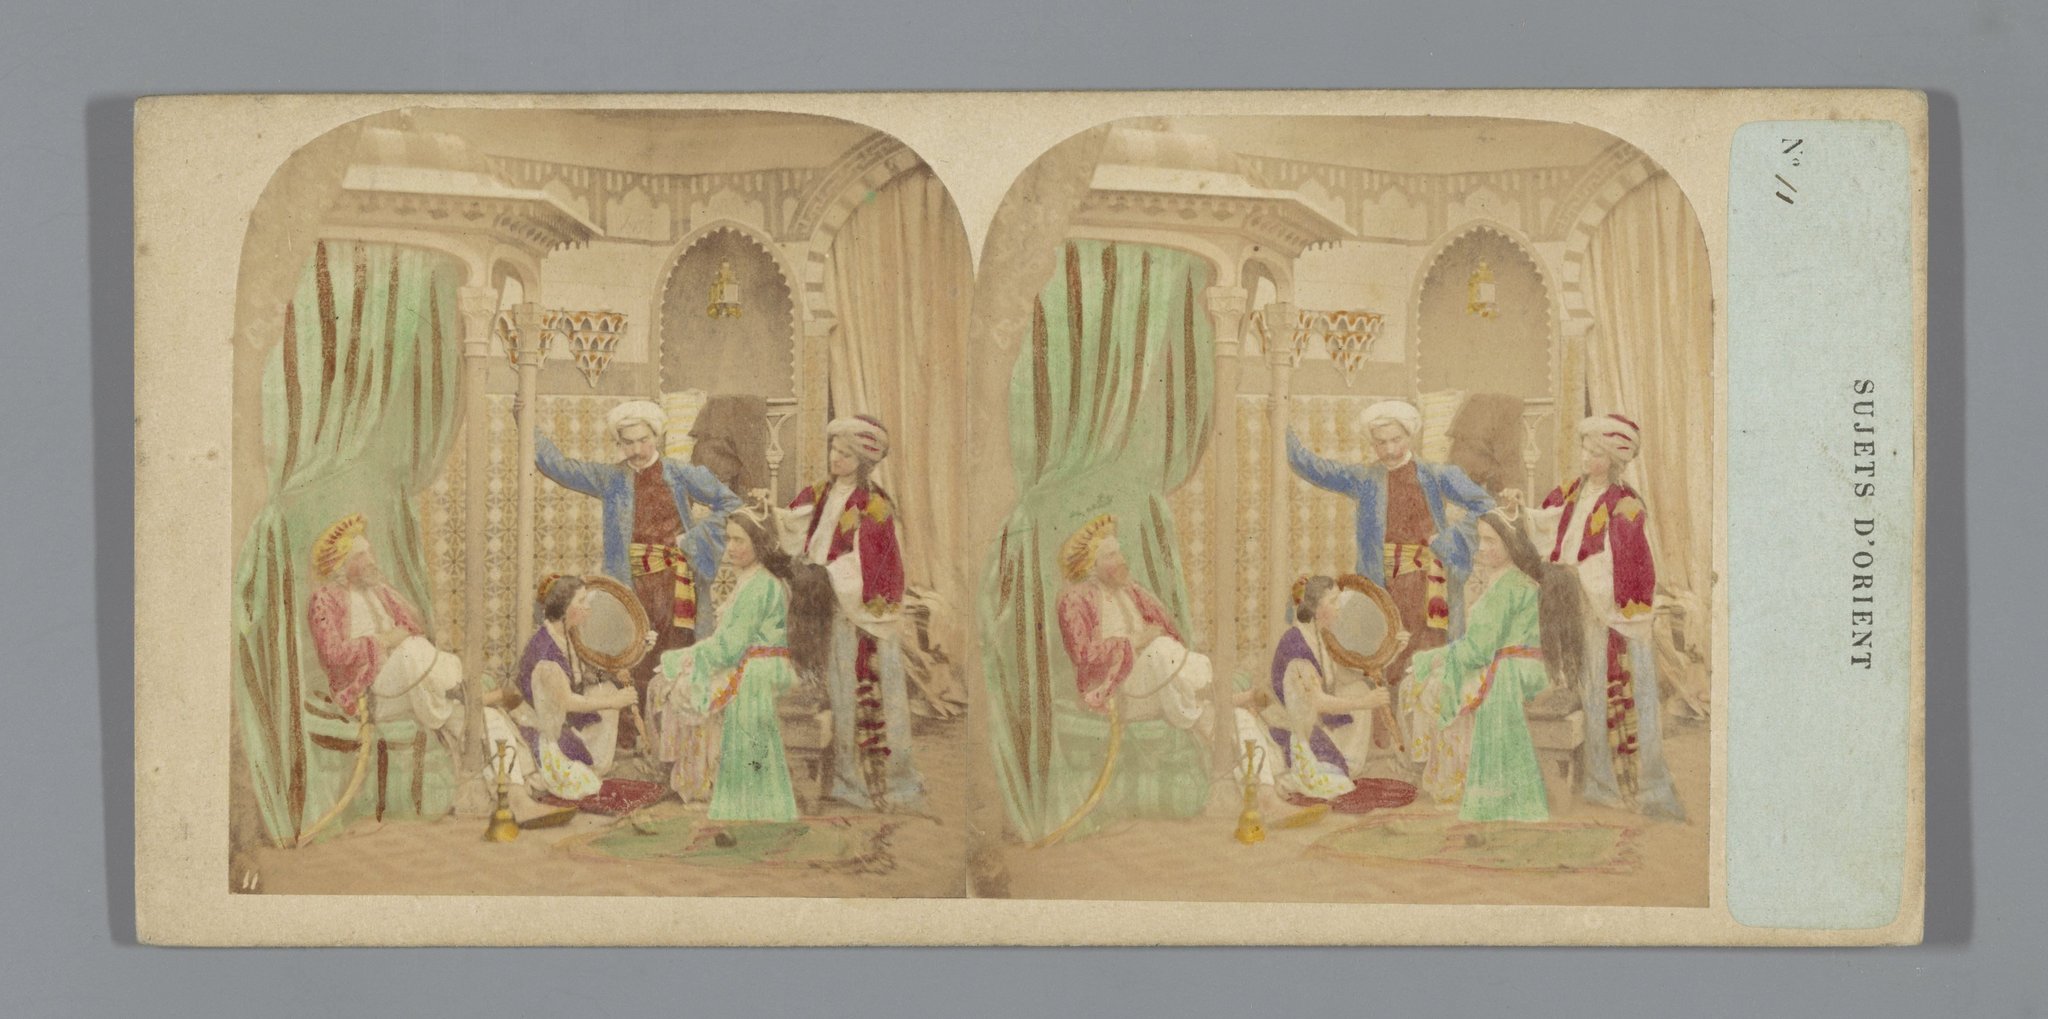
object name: stereograph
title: Oriëntaals tafereel met een groep mensen rondom een spiegel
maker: Anonymous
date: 1852-1863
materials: cardboard, paper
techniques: albumen print, hand coloring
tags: mirror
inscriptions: number: ‘11’, retailer's mark: ‘Feldbrugge & Co./ Groningen’, inscription: ‘cl 100’